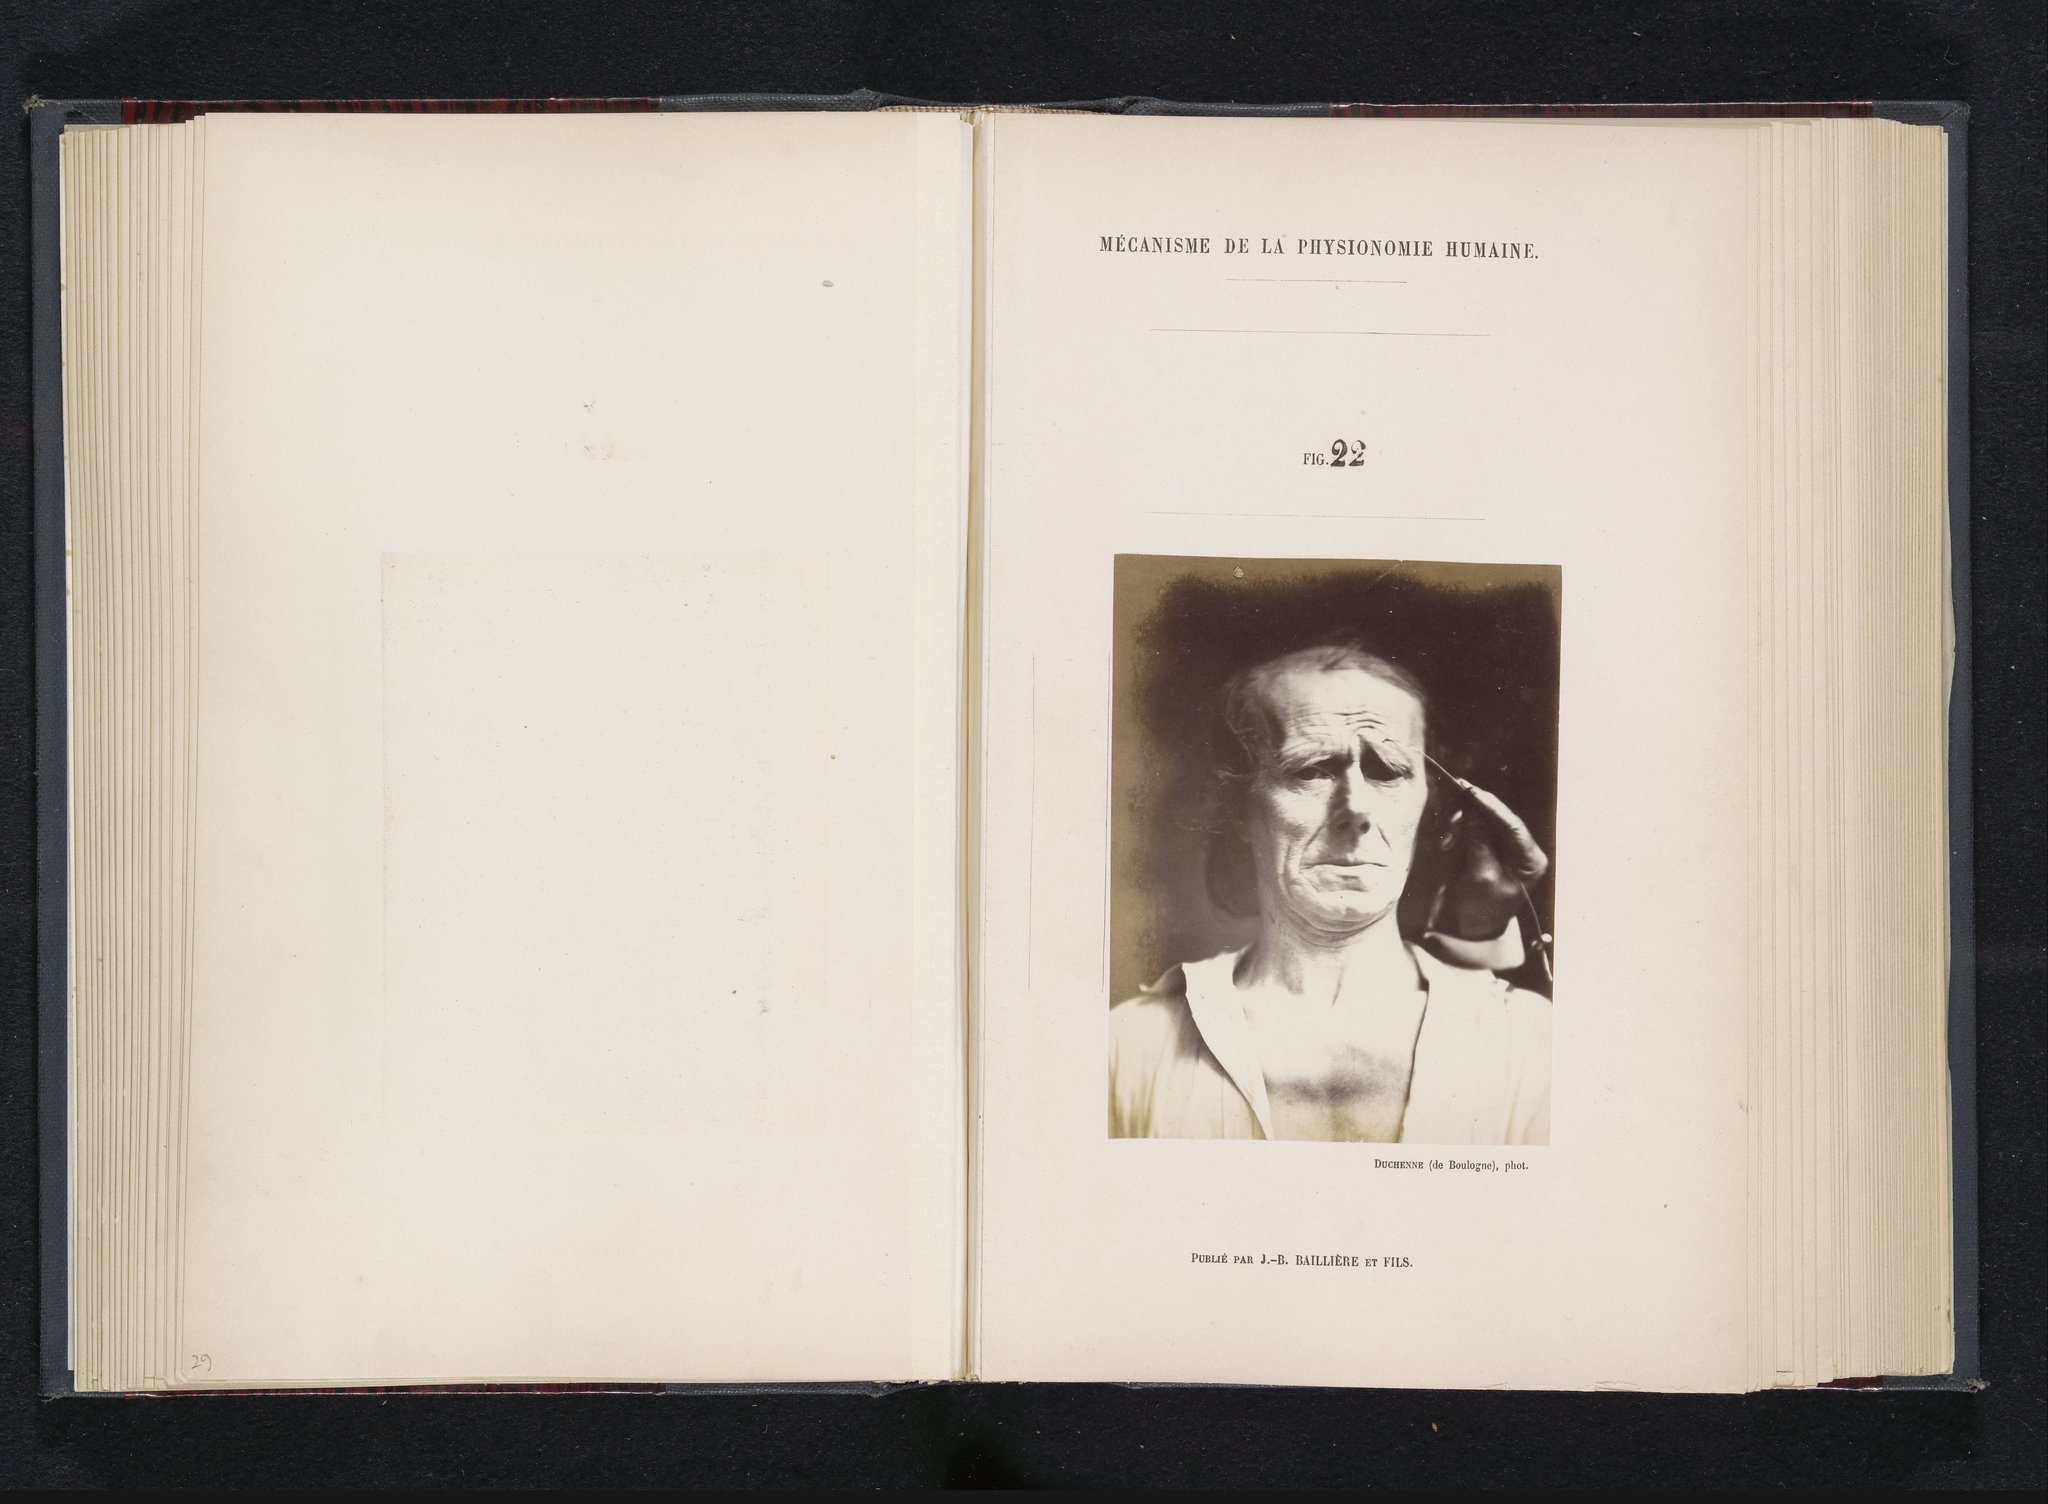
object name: photograph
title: Portret van een proefpersoon tijdens elektrostimulatie: 'un vieillard'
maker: guillaume benjamin amand duchenne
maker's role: fotograaf, medicus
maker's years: 1806-1875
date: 1860-1862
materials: paper, photographic support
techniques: albumen print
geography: paris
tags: face, physiology and anatomy ~ nervous system, neurology, physiology and anatomy, old man, morphology of facial expression, physiognomy, experiment, test ~ science and technology, france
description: Ongenummerde pagina met foto 22 uit Mécanisme de la physionomie humaine ou analyse électro-physiologique de l'expression des passions (Atlas).